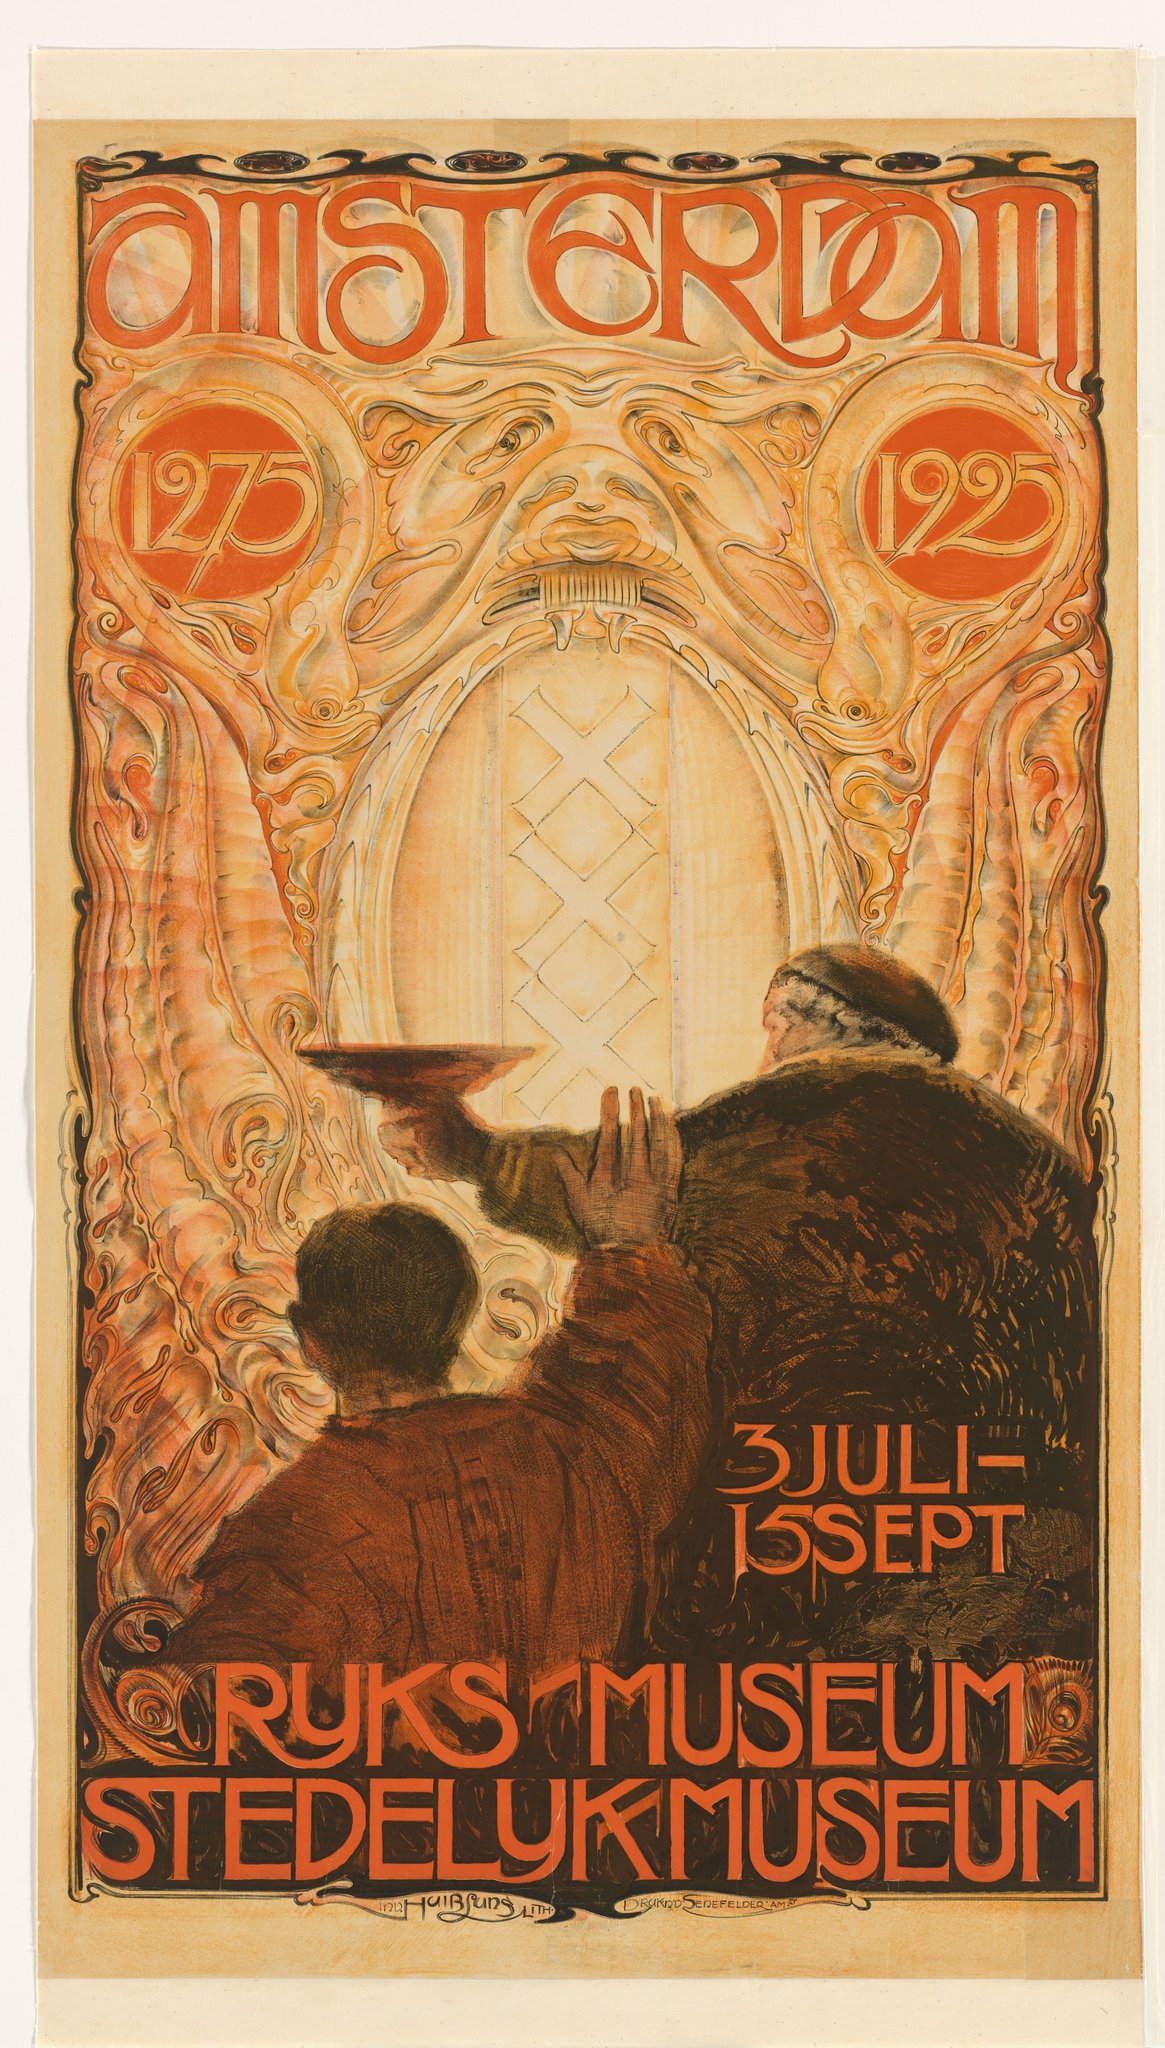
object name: poster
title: Amsterdam 1275 1925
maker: huib luns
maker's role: draughtsman, print maker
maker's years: 1881-1942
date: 1925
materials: paper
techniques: lithograph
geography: amsterdam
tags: coat of arms (as symbol of the state, etc.) (+ city; municipal), exhibition ~ art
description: Affiche voor de historische tentoonstelling ter ere van het 650-jarig bestaan van de stad Amsterdam, georganiseerd door het genootschap Amstelodamum en gehouden in het Rijksmuseum en Stedelijk Museum van 3 juli tot en met 15 september 1925. In het midden het wapen van Amsterdam met daaromheen kwabversieringen. Op de voorgrond twee figuren.